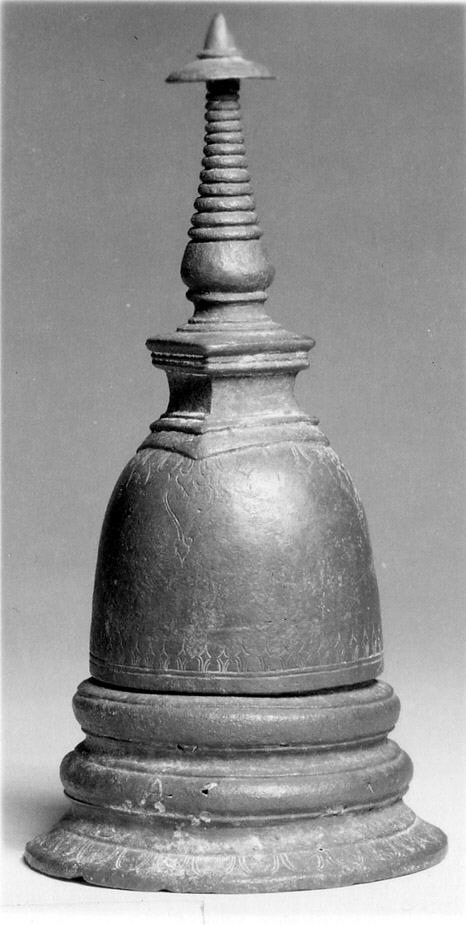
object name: stupa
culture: sri lankan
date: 1101-1200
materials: bronze